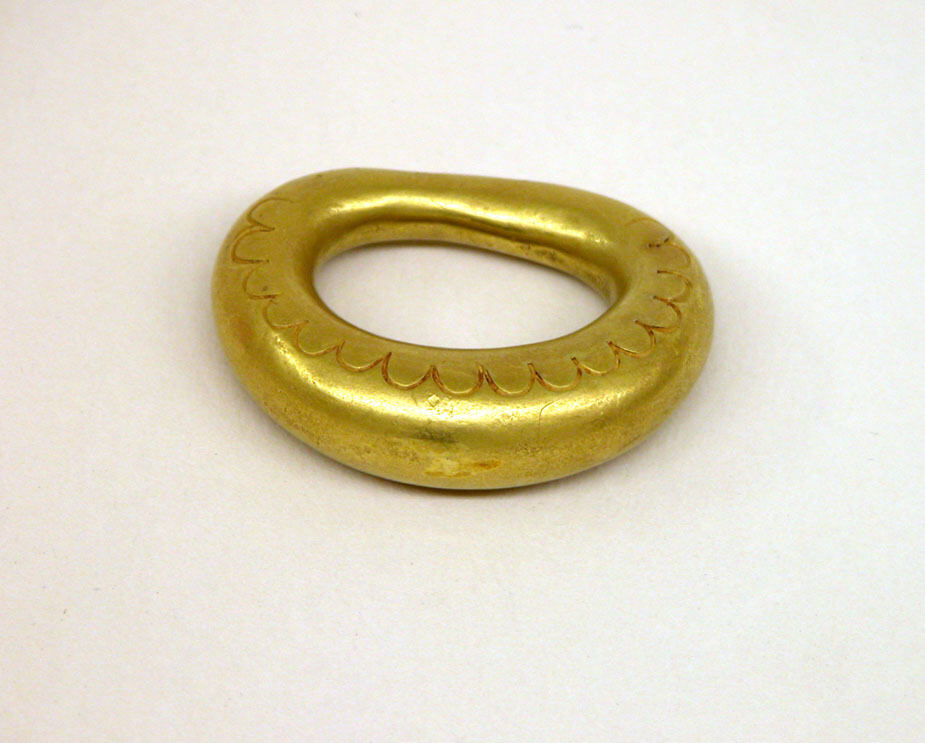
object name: pendant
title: Circular Pendant with Incised Scalloped Design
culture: indonesian, javanese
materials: gold